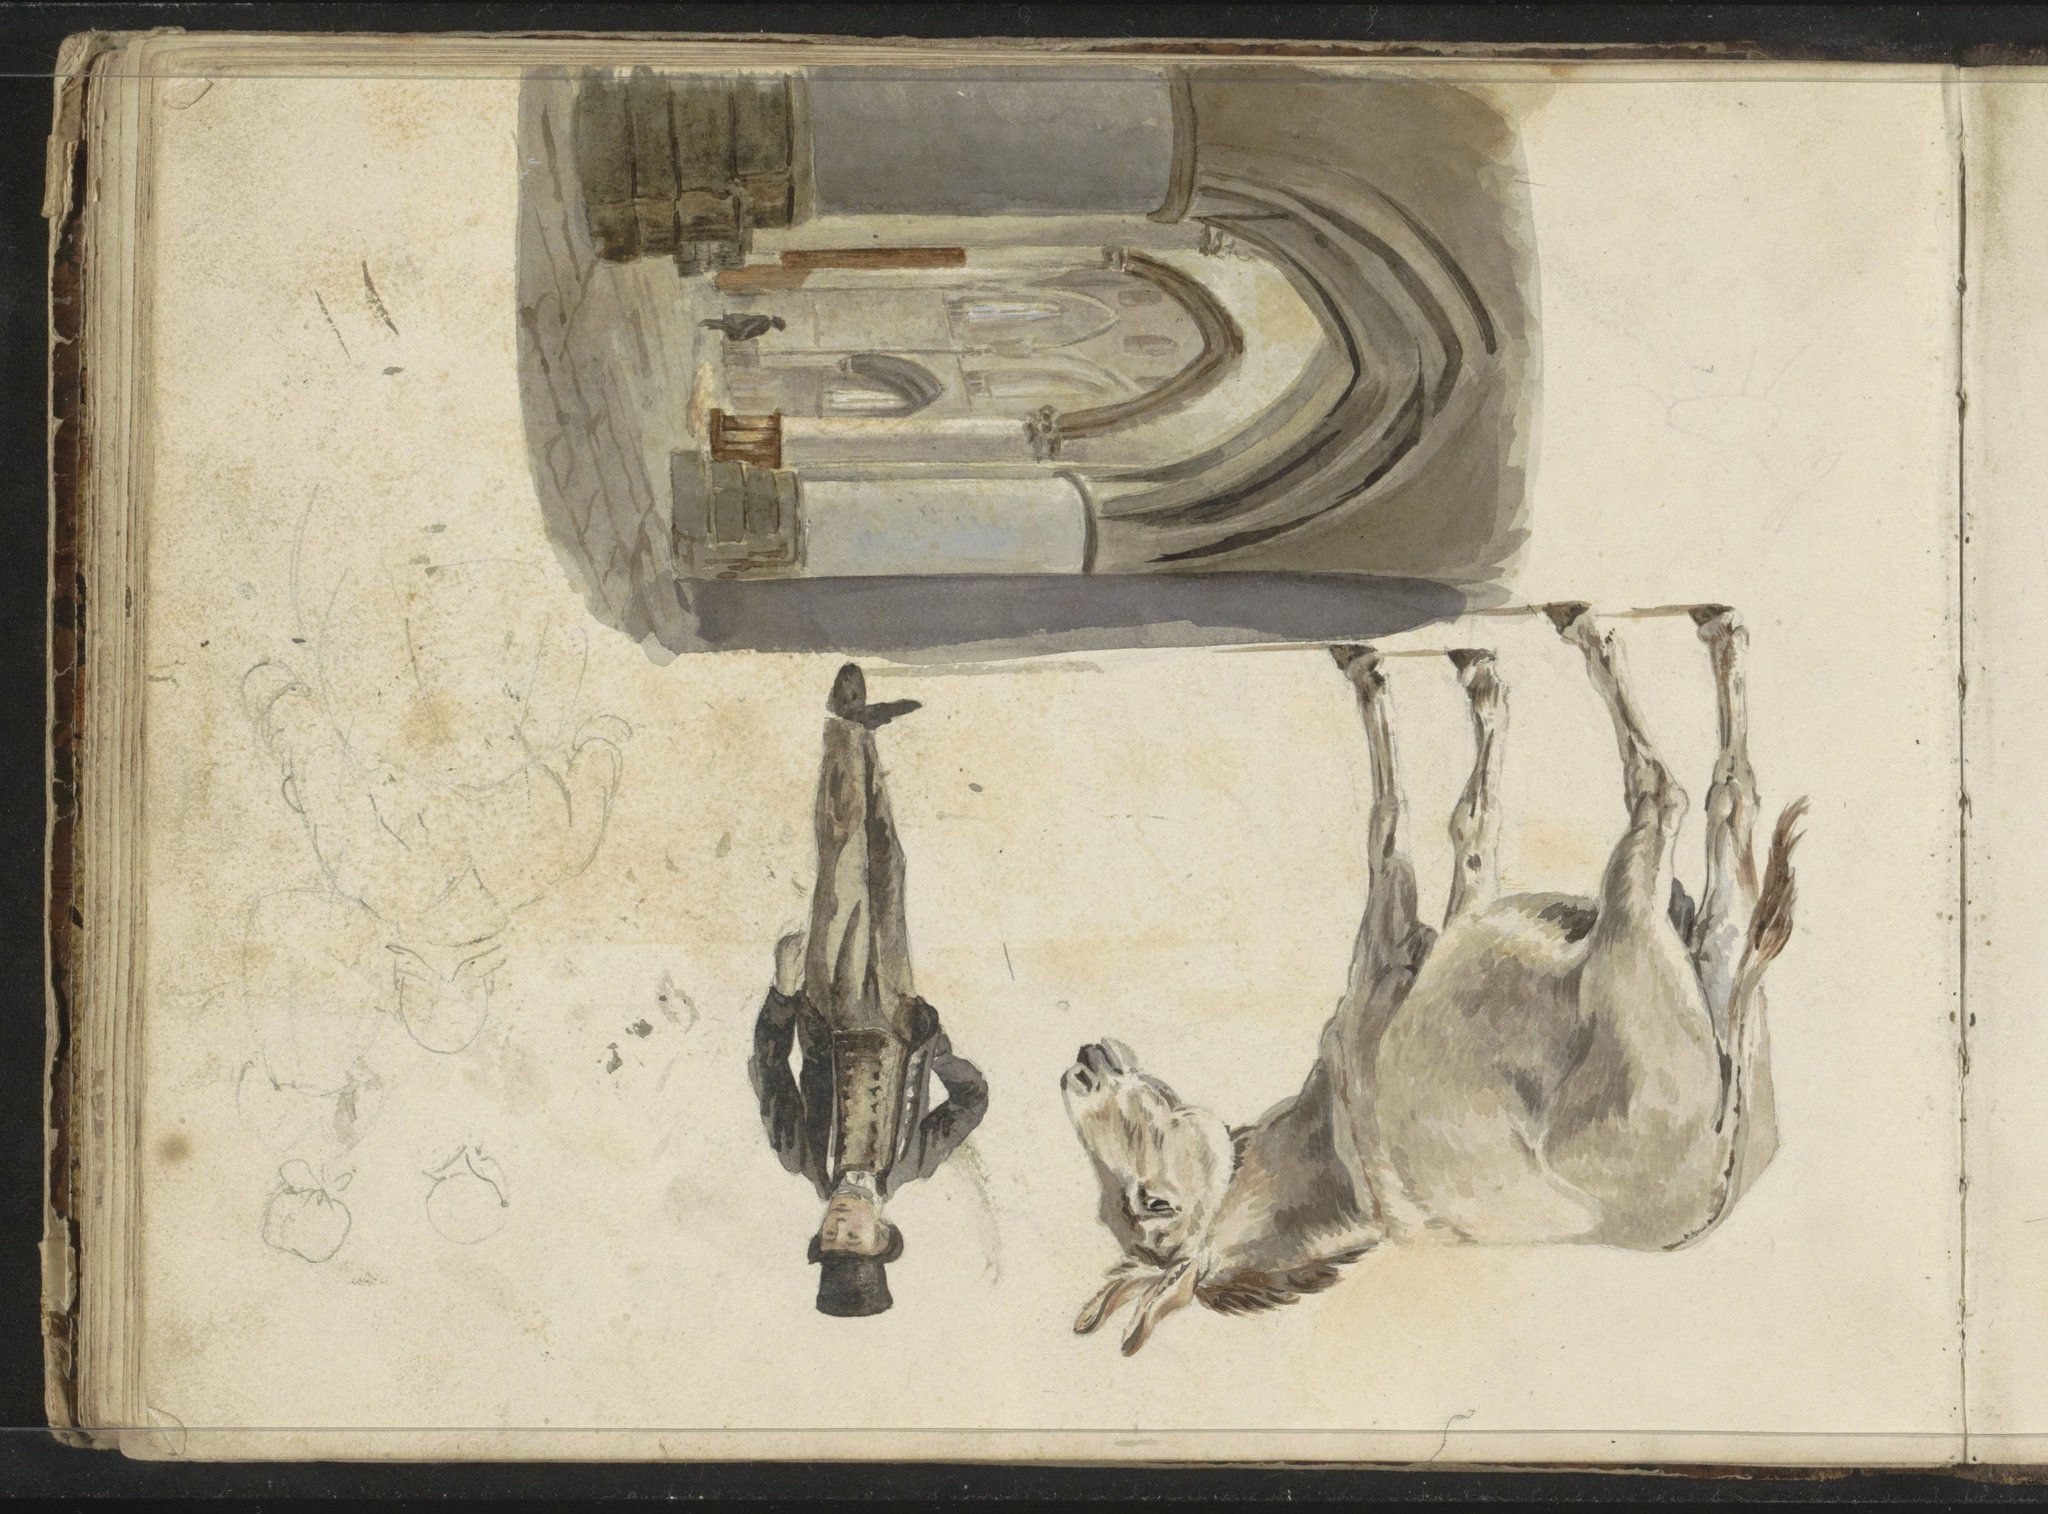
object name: sketchbook leaf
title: Man in een kerkinterieur, een ezel en figuurstudies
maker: willem troost (ii)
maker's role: draughtsman, painter, print maker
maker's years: 1812-1893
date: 1822-1893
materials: paper, pencil, watercolor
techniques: brush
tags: anatomy (non-medical), interior of church, mule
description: Blad 59 verso uit een schetsboek met 36 bladen.